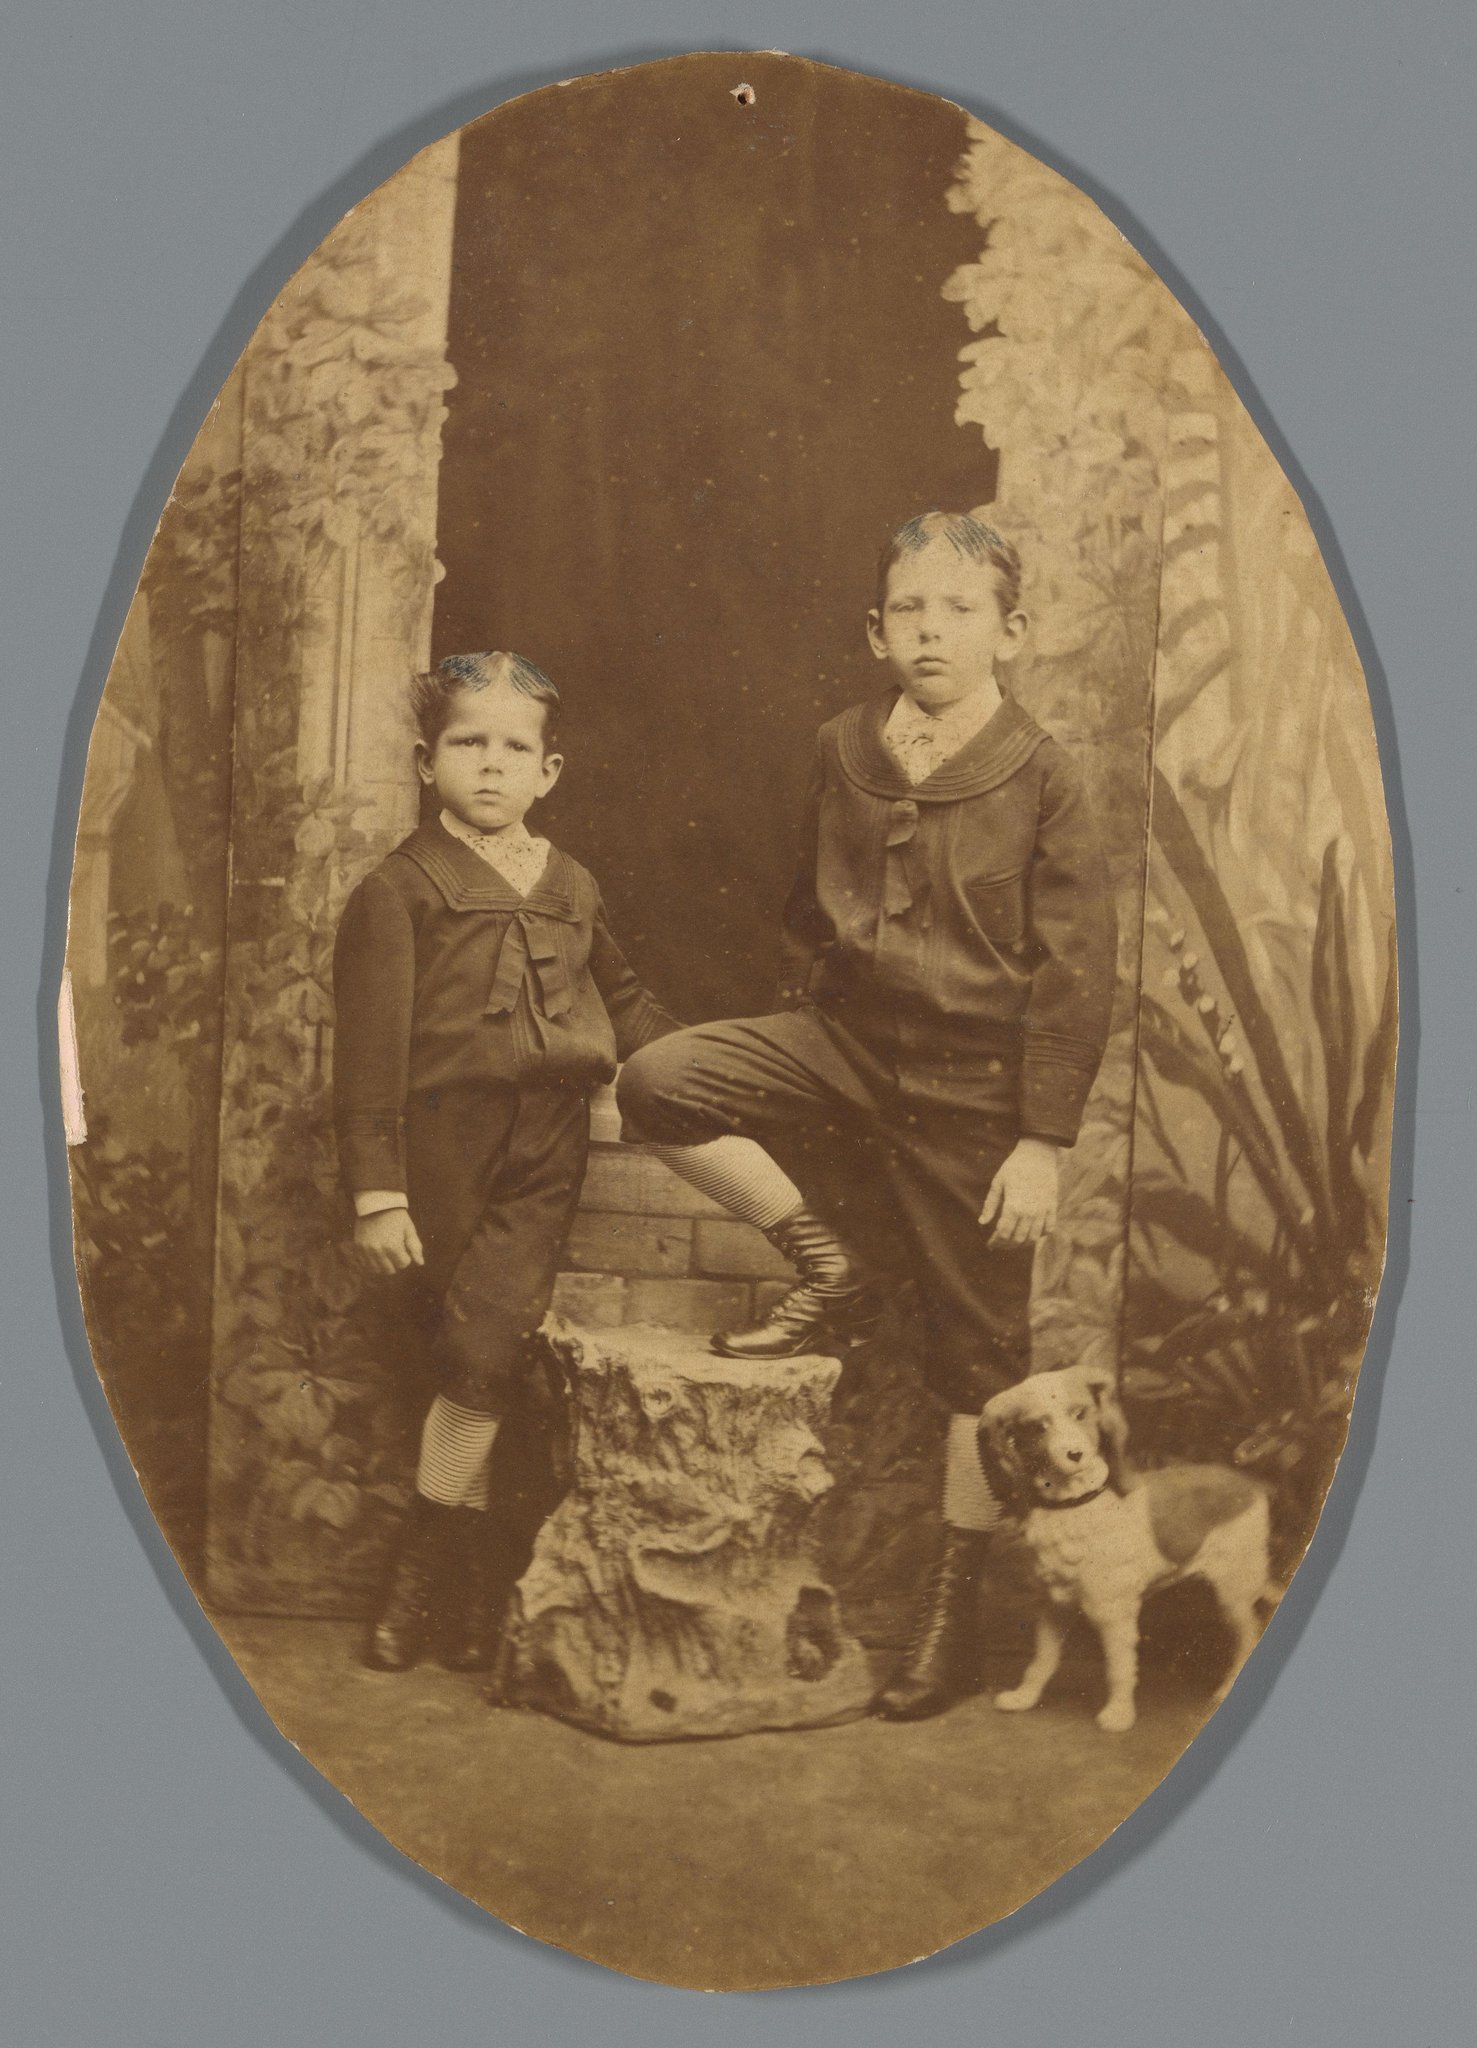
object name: photograph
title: Studioportret van twee staande jongens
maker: heinrich wilhelm wollrabe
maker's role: fotograaf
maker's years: 1843-1928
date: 1880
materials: cardboard, photographic support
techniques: albumen print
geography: the hague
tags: batavia, karel frederik van den berg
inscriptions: name: ‘H.W. Wollrabe’, inscription: ‘Oom Karel / Vader in 1880’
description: Studioportret van twee staande jongens voor een decor. De jongen rechts is Karel van den Berg.